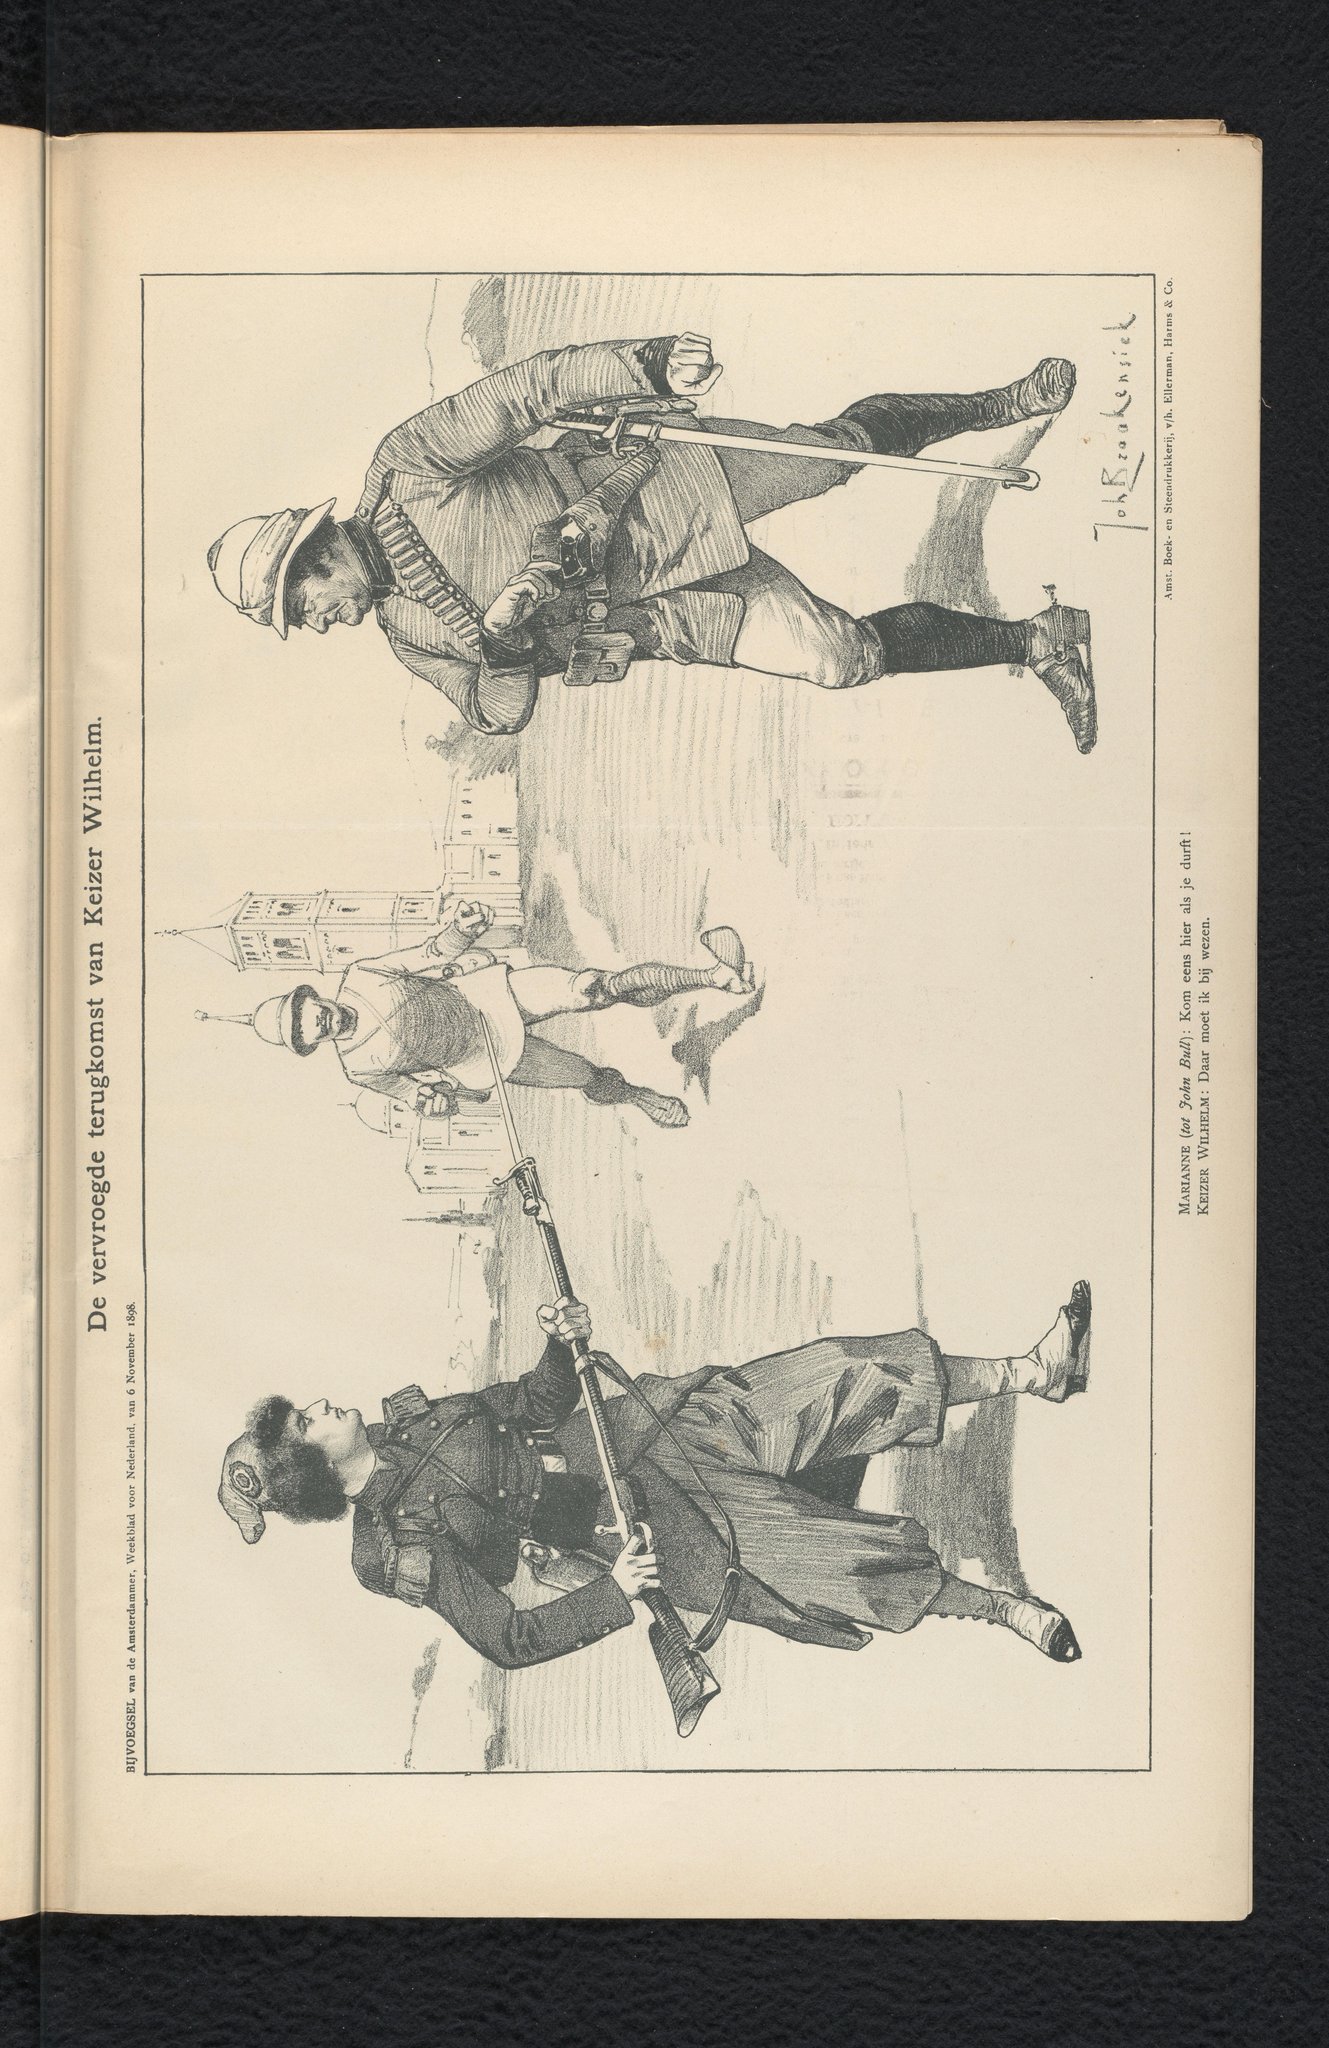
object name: cartoon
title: De vervroegde terugkomst van Keizer Wilhelm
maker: johan braakensiek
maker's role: draughtsman, print maker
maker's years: 1858-1940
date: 1898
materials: paper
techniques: lithograph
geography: amsterdam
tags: wilhelm ii (keizer van duitsland), personifications of countries, nations, states, districts, etc., challenging the enemy, political caricatures and satires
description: De Duitse keizer Wilhelm II haast zich om aanwezig te zijn bij een gewapend treffen tussen Marianne (Frankrijk) en John Bull (Engeland).